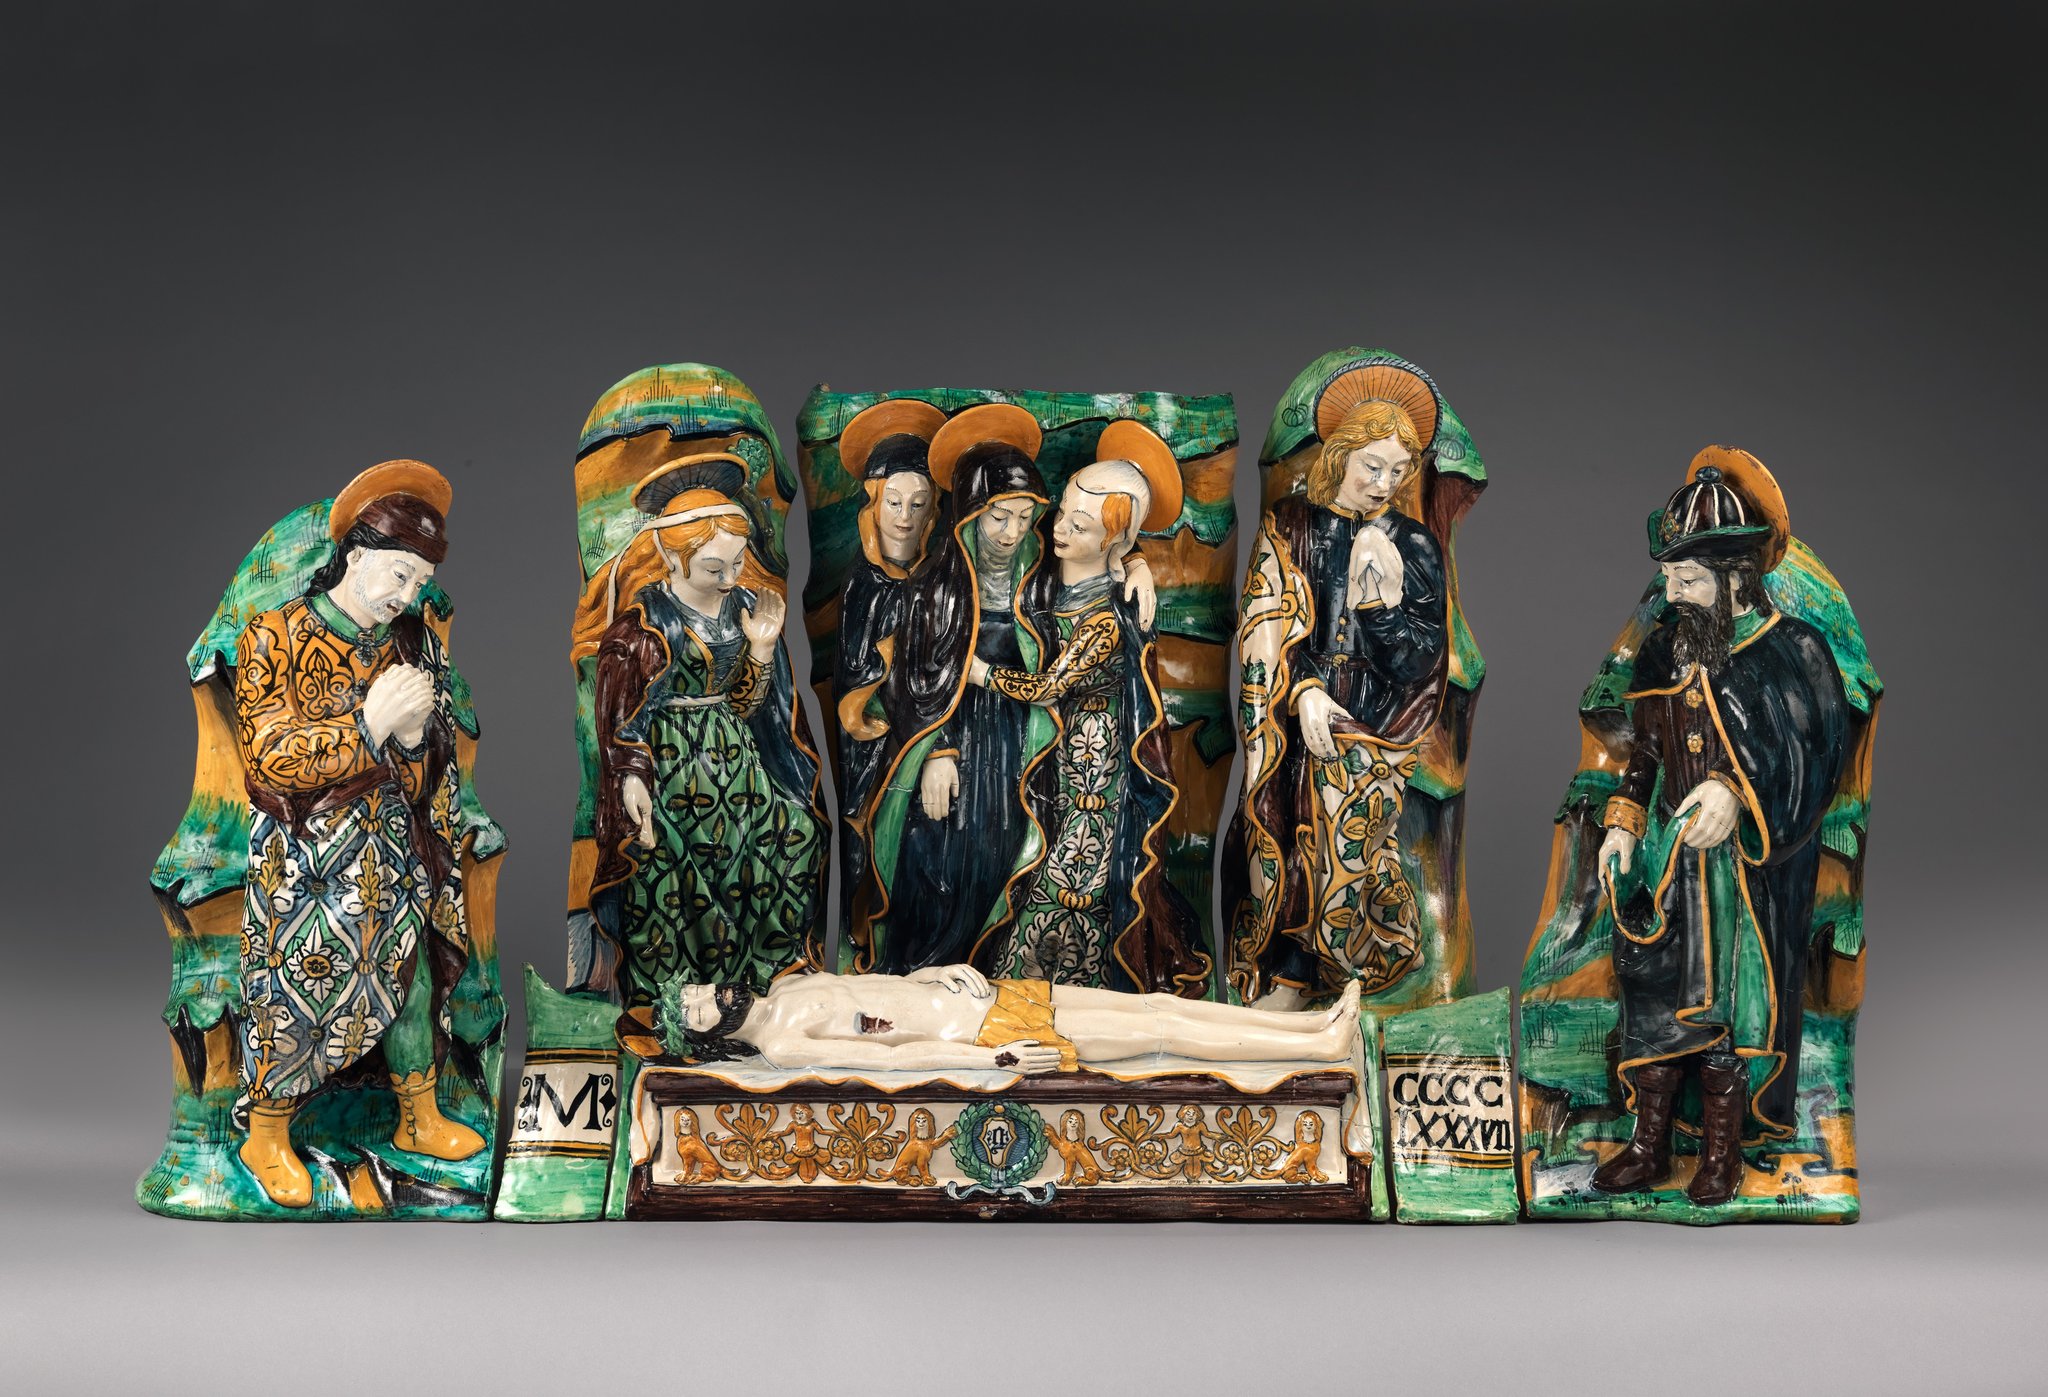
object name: group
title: Sculptural group with The Lamentation Over the Dead Christ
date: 1487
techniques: maiolica, glazing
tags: christ,mary magdalene,virgin mary,lamentation